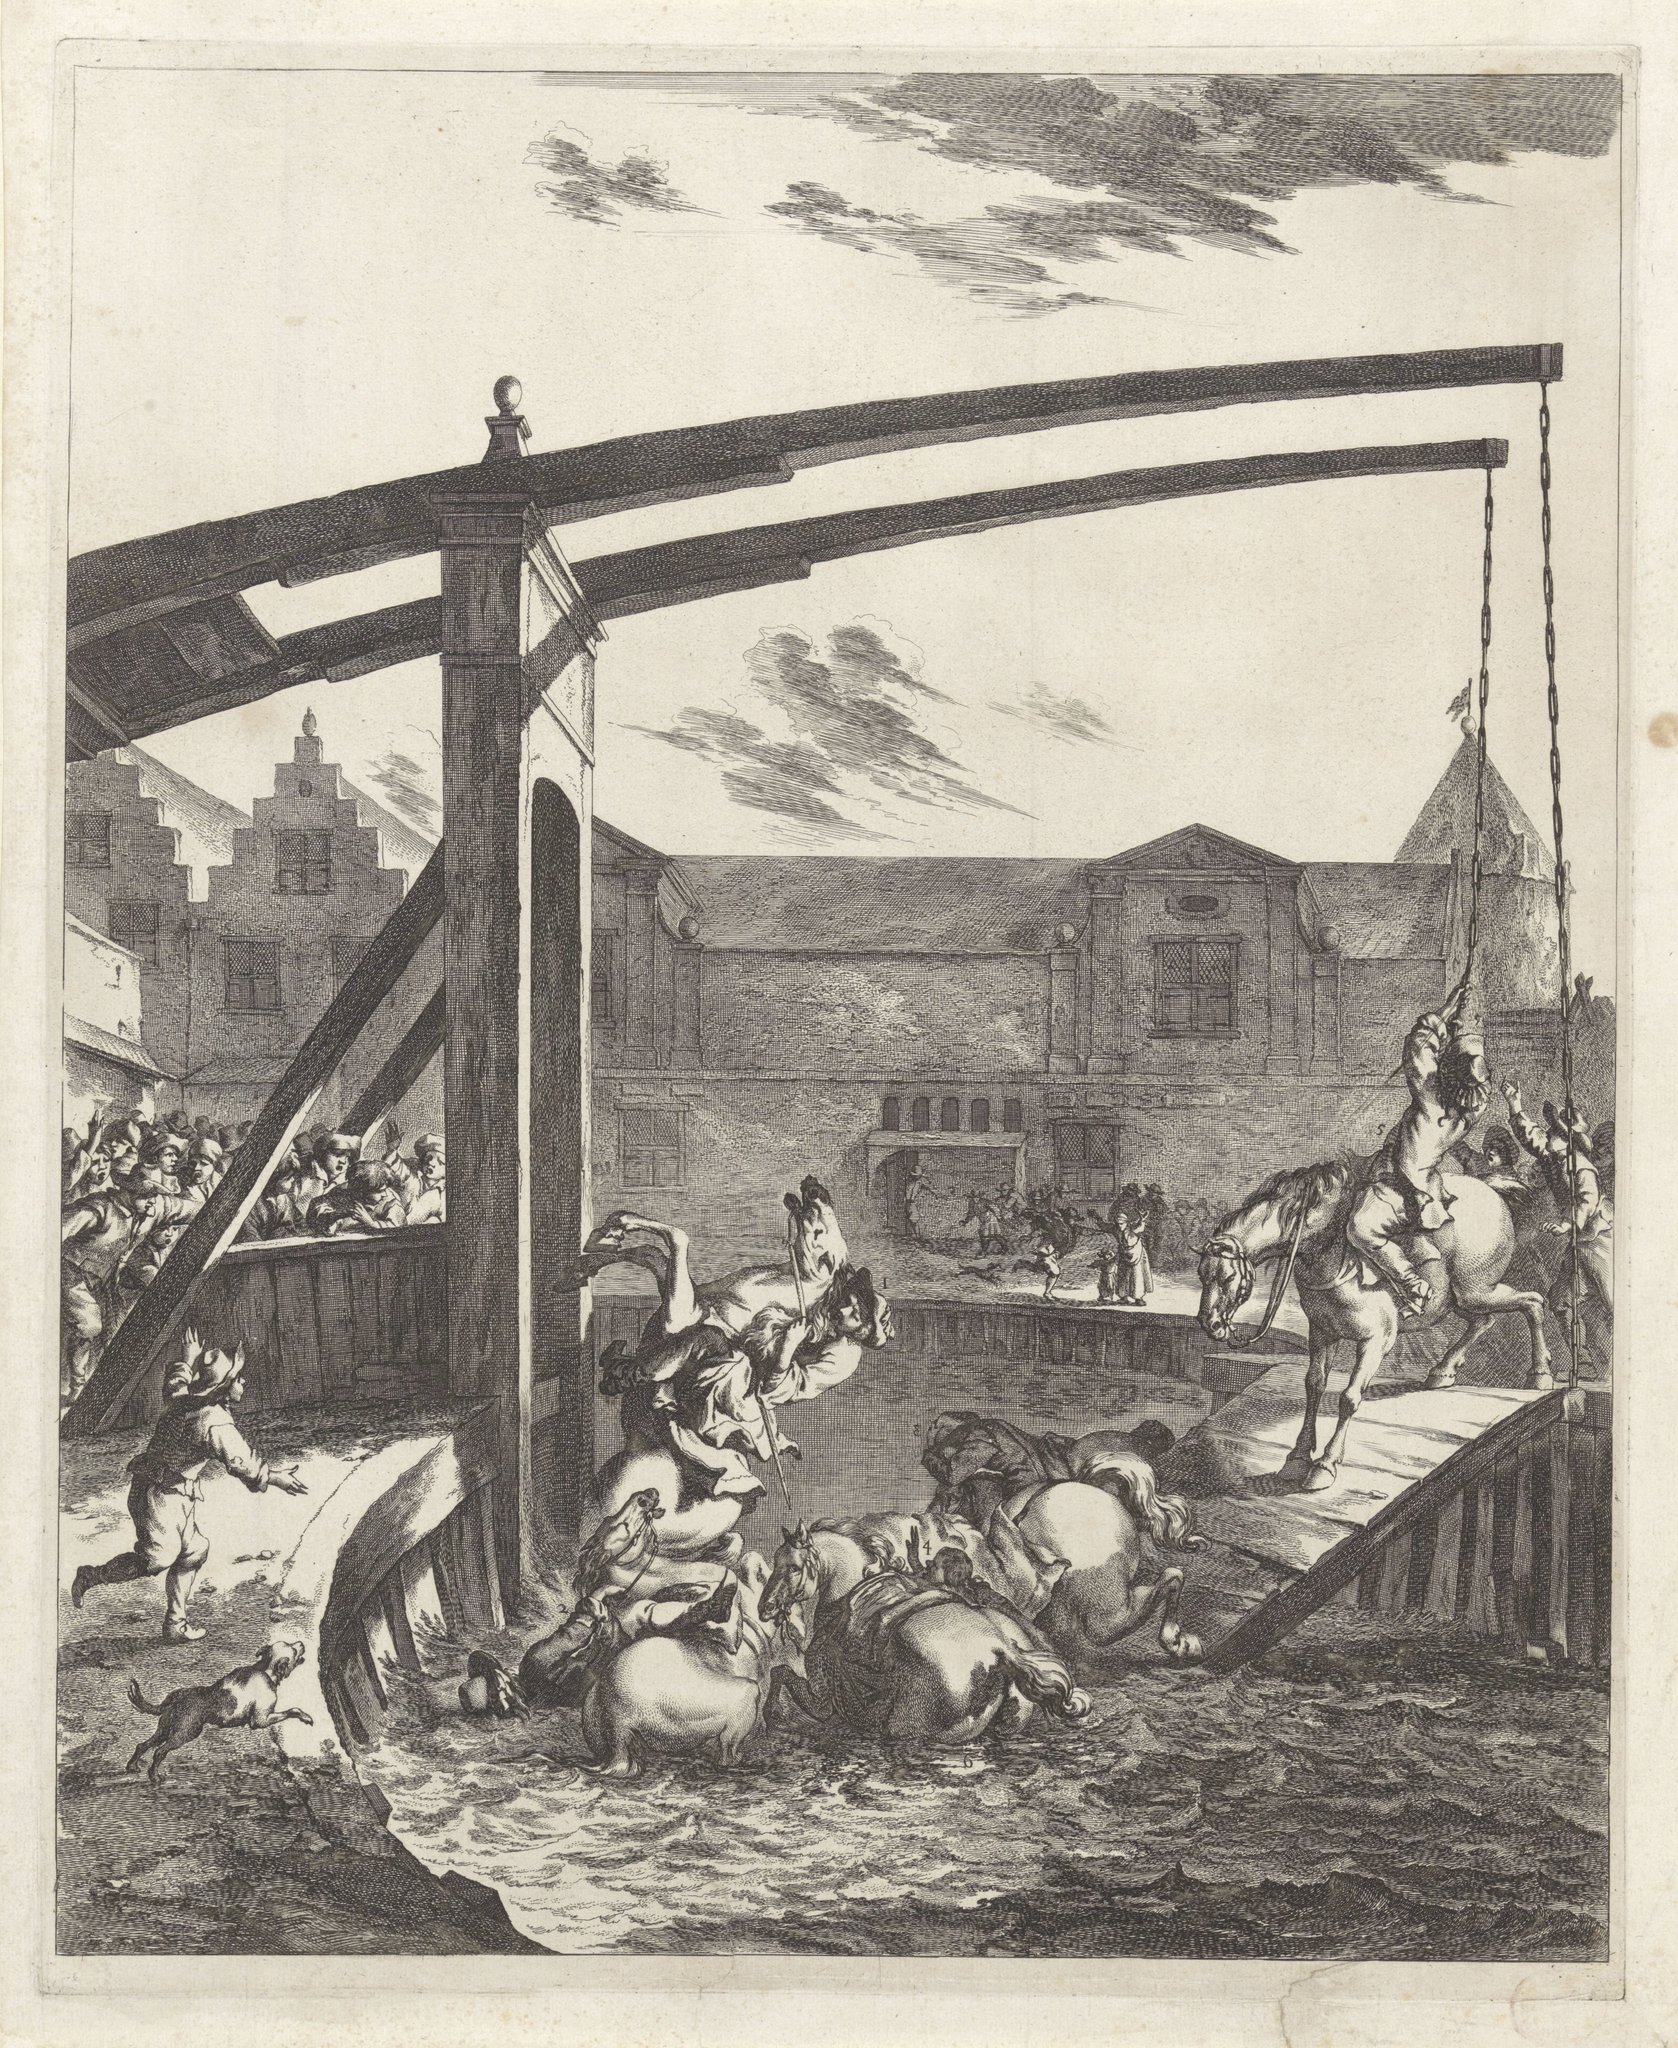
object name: print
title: Ongeluk van graaf Johan Maurits op de brug van Franeker, 1665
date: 1665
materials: paper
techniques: etching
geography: northern netherlands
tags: earl, johan maurits graaf van nassau-siegen, collapsing building, bridge, accident with horse (or kindred animal)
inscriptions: collector's mark: Lugt 12, collector's mark: Lugt 573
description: Ongeluk van graaf Johan Maurits op de brug van Franeker, 6 januari 1665. De ophaalbrug waar de graaf met zijn gevolg overheen rijdt stort in en de graaf valt in het water.